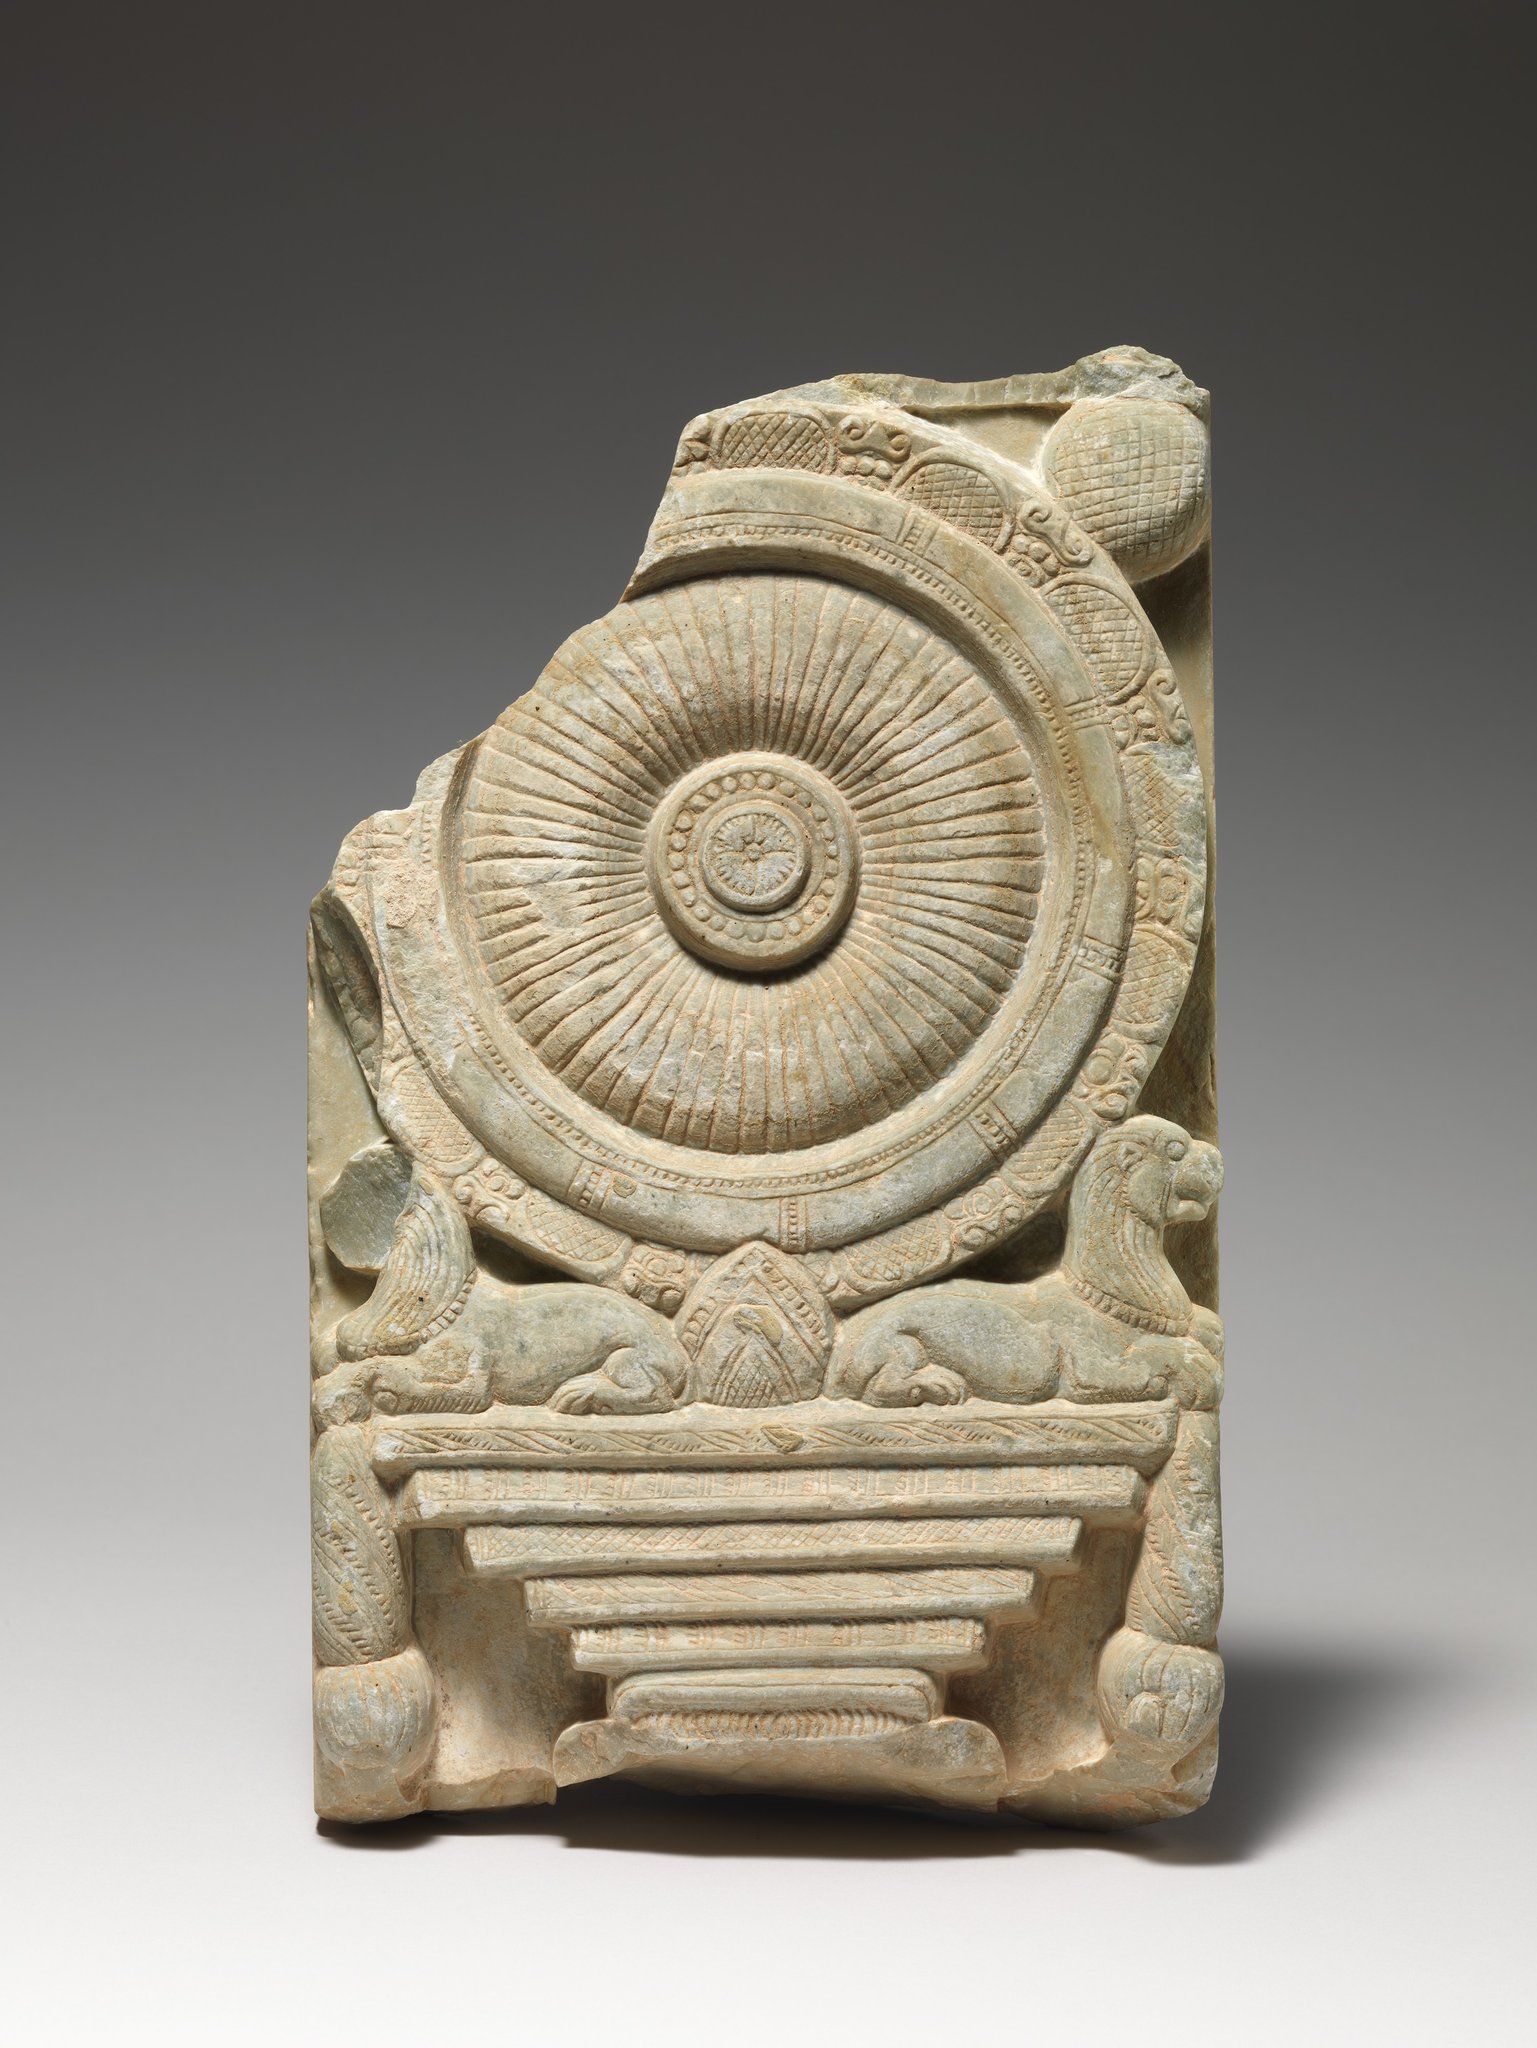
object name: relief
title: Dharma-wheel pilaster (dharmacakrastambha)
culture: indian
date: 201-233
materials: limestone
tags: early andhra,lions,buddhism